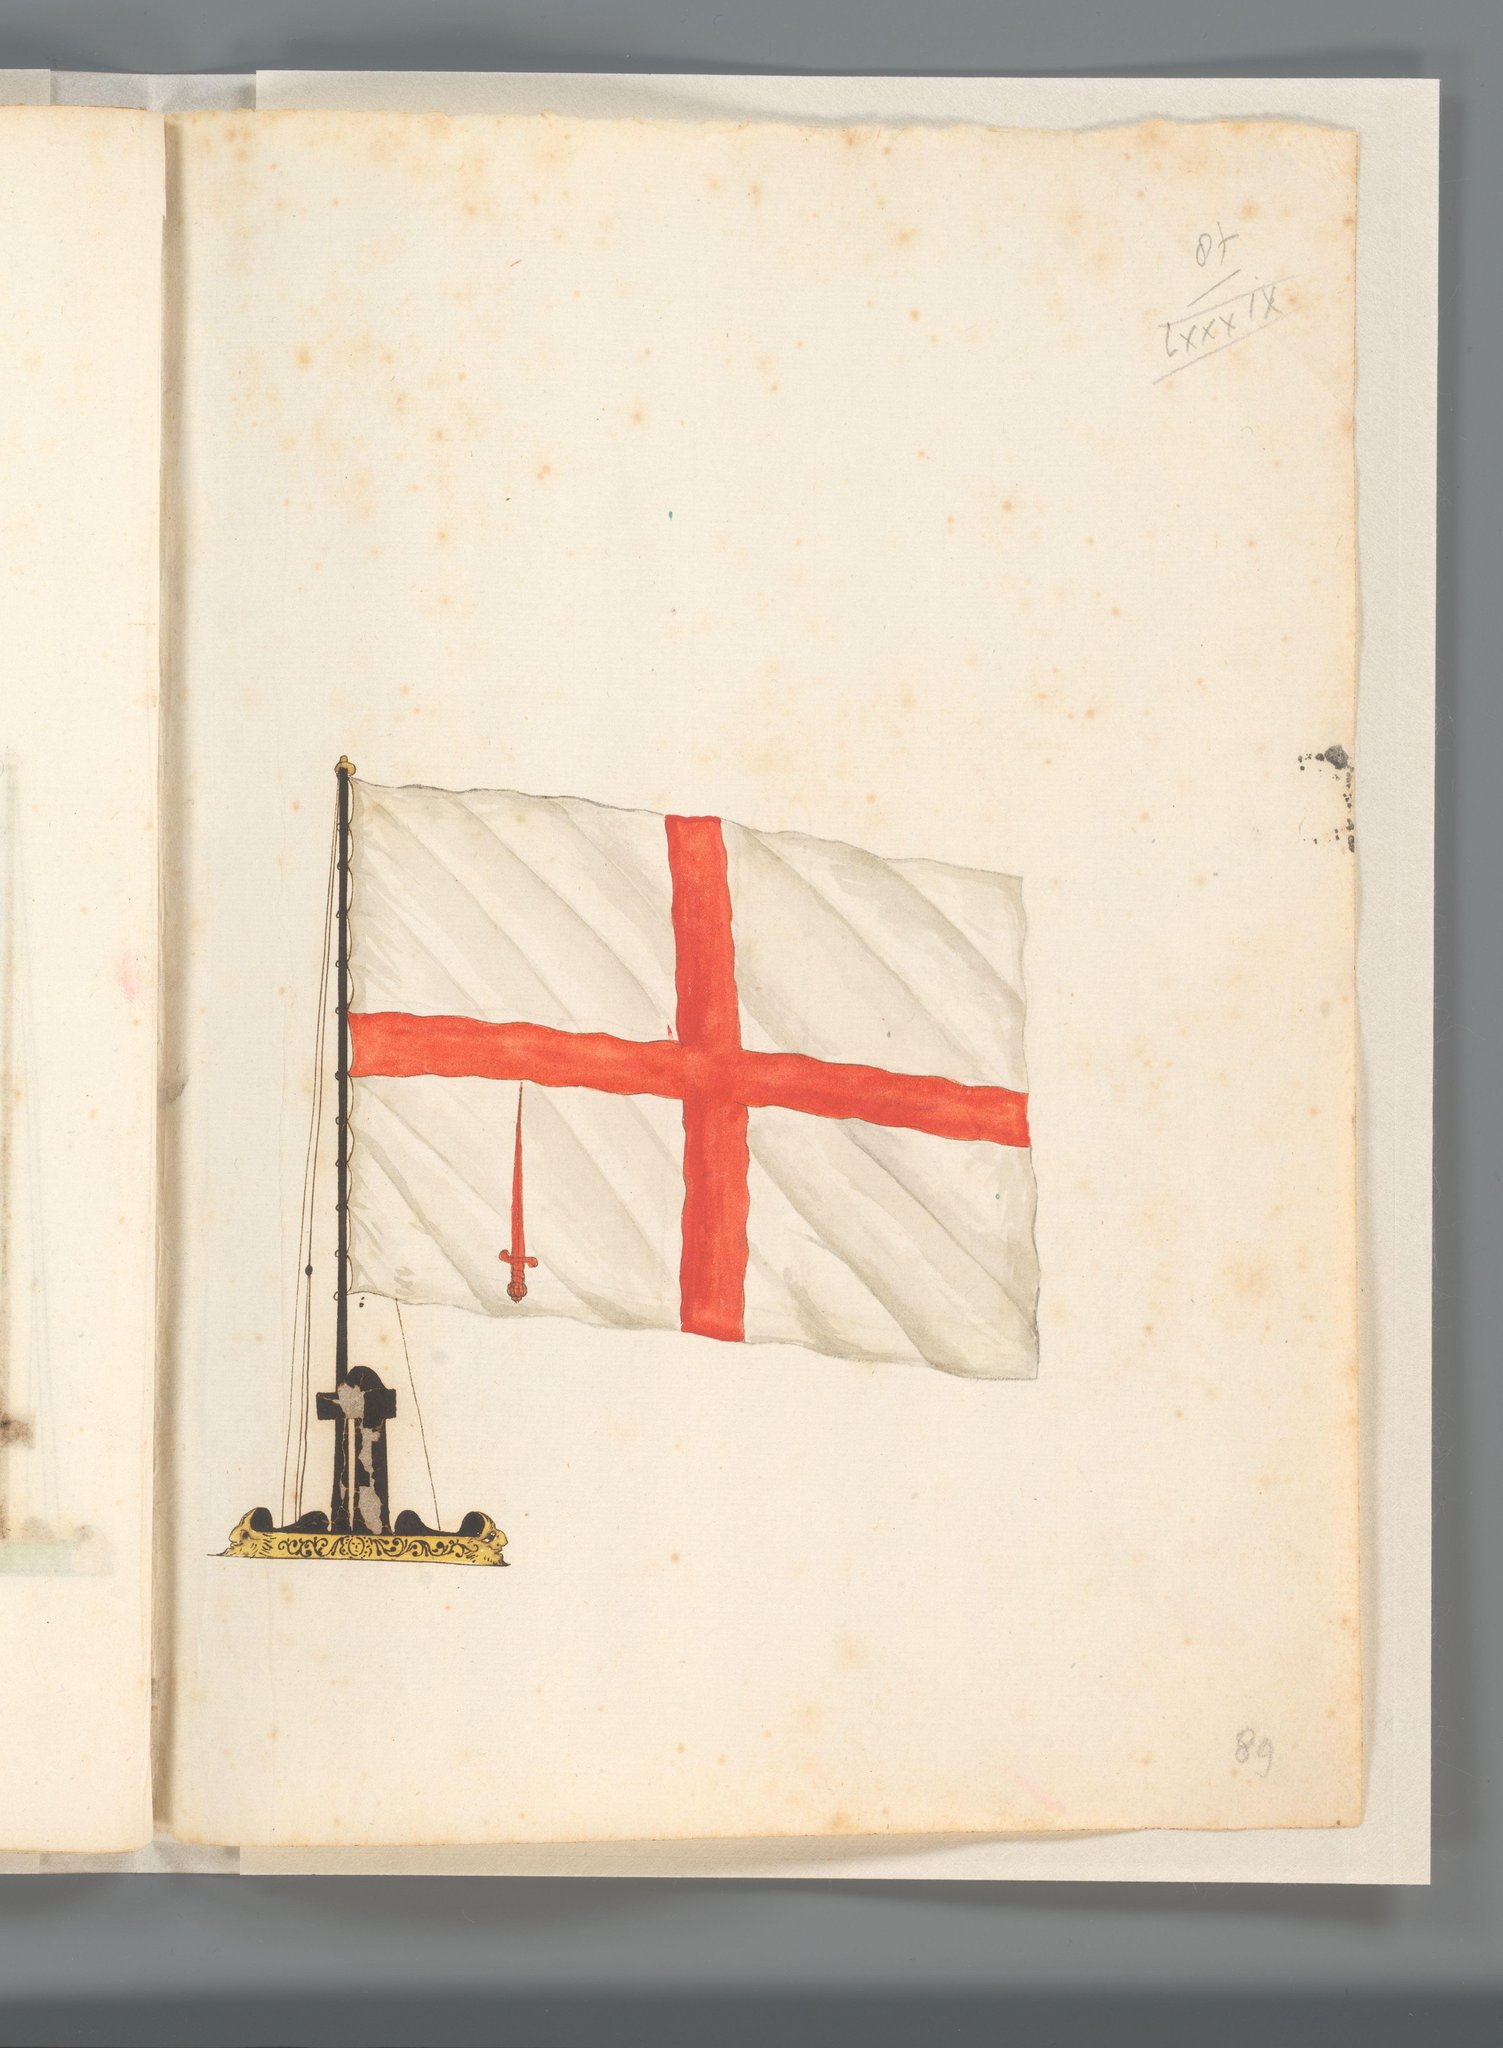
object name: drawing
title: Vlag van Londen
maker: Anonymous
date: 1667-1670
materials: ink, paper, watercolor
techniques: brush, pen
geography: france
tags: flag, colours (as symbol of the state, etc.), london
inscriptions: number: ‘87 / LXXXIX / 89’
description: Vlag van Londen, het rode kruis van Sint-Joris (Saint George's Cross), de Engelse vlag, op een wit veld, in het derde kwartier een rood zwaard (van de apostel Paulus). Vlag op vlaggensteng en mastvoet. Afgebeeld op folio 45r. Onderdeel van een vlaggenboek met vlaggen uit Europa, Noord-Afrika, Nabije en Verre Oosten.